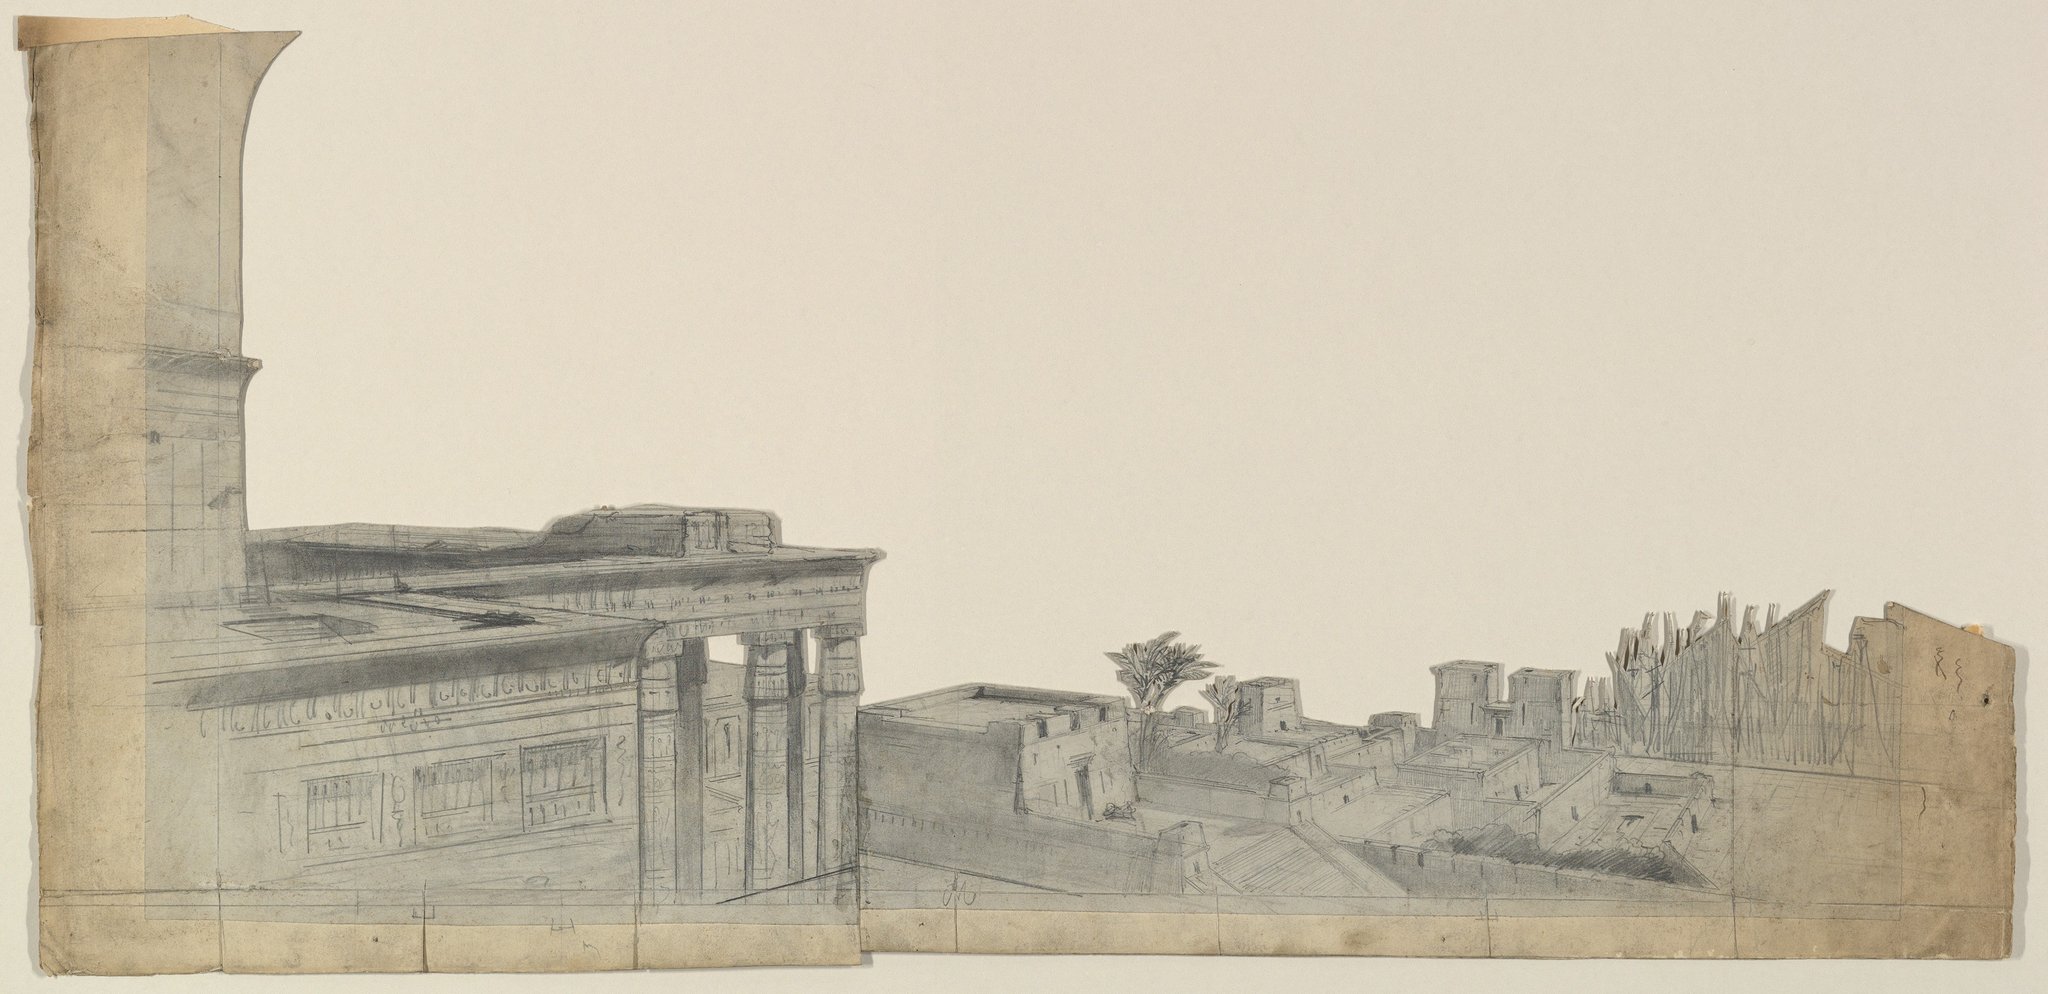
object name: drawing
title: Design for a Stage Set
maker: eugène cicéri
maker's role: artist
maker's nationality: french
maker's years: 1813-1890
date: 1830-1890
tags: buildings,stage design